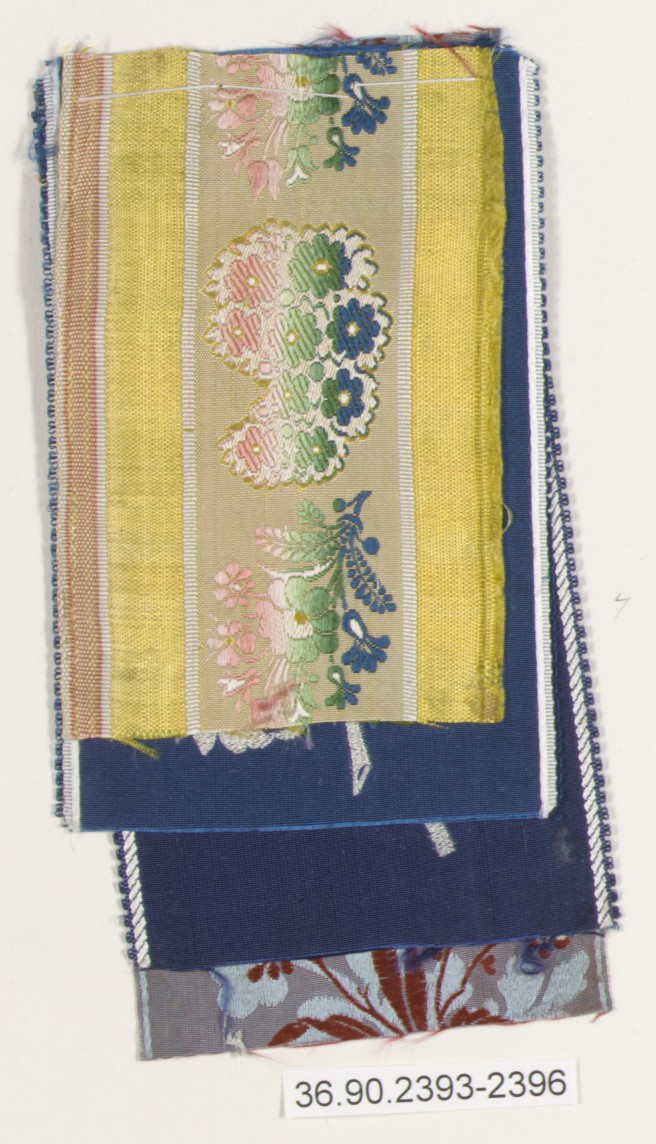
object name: ribbon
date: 1801-1900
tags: flowers